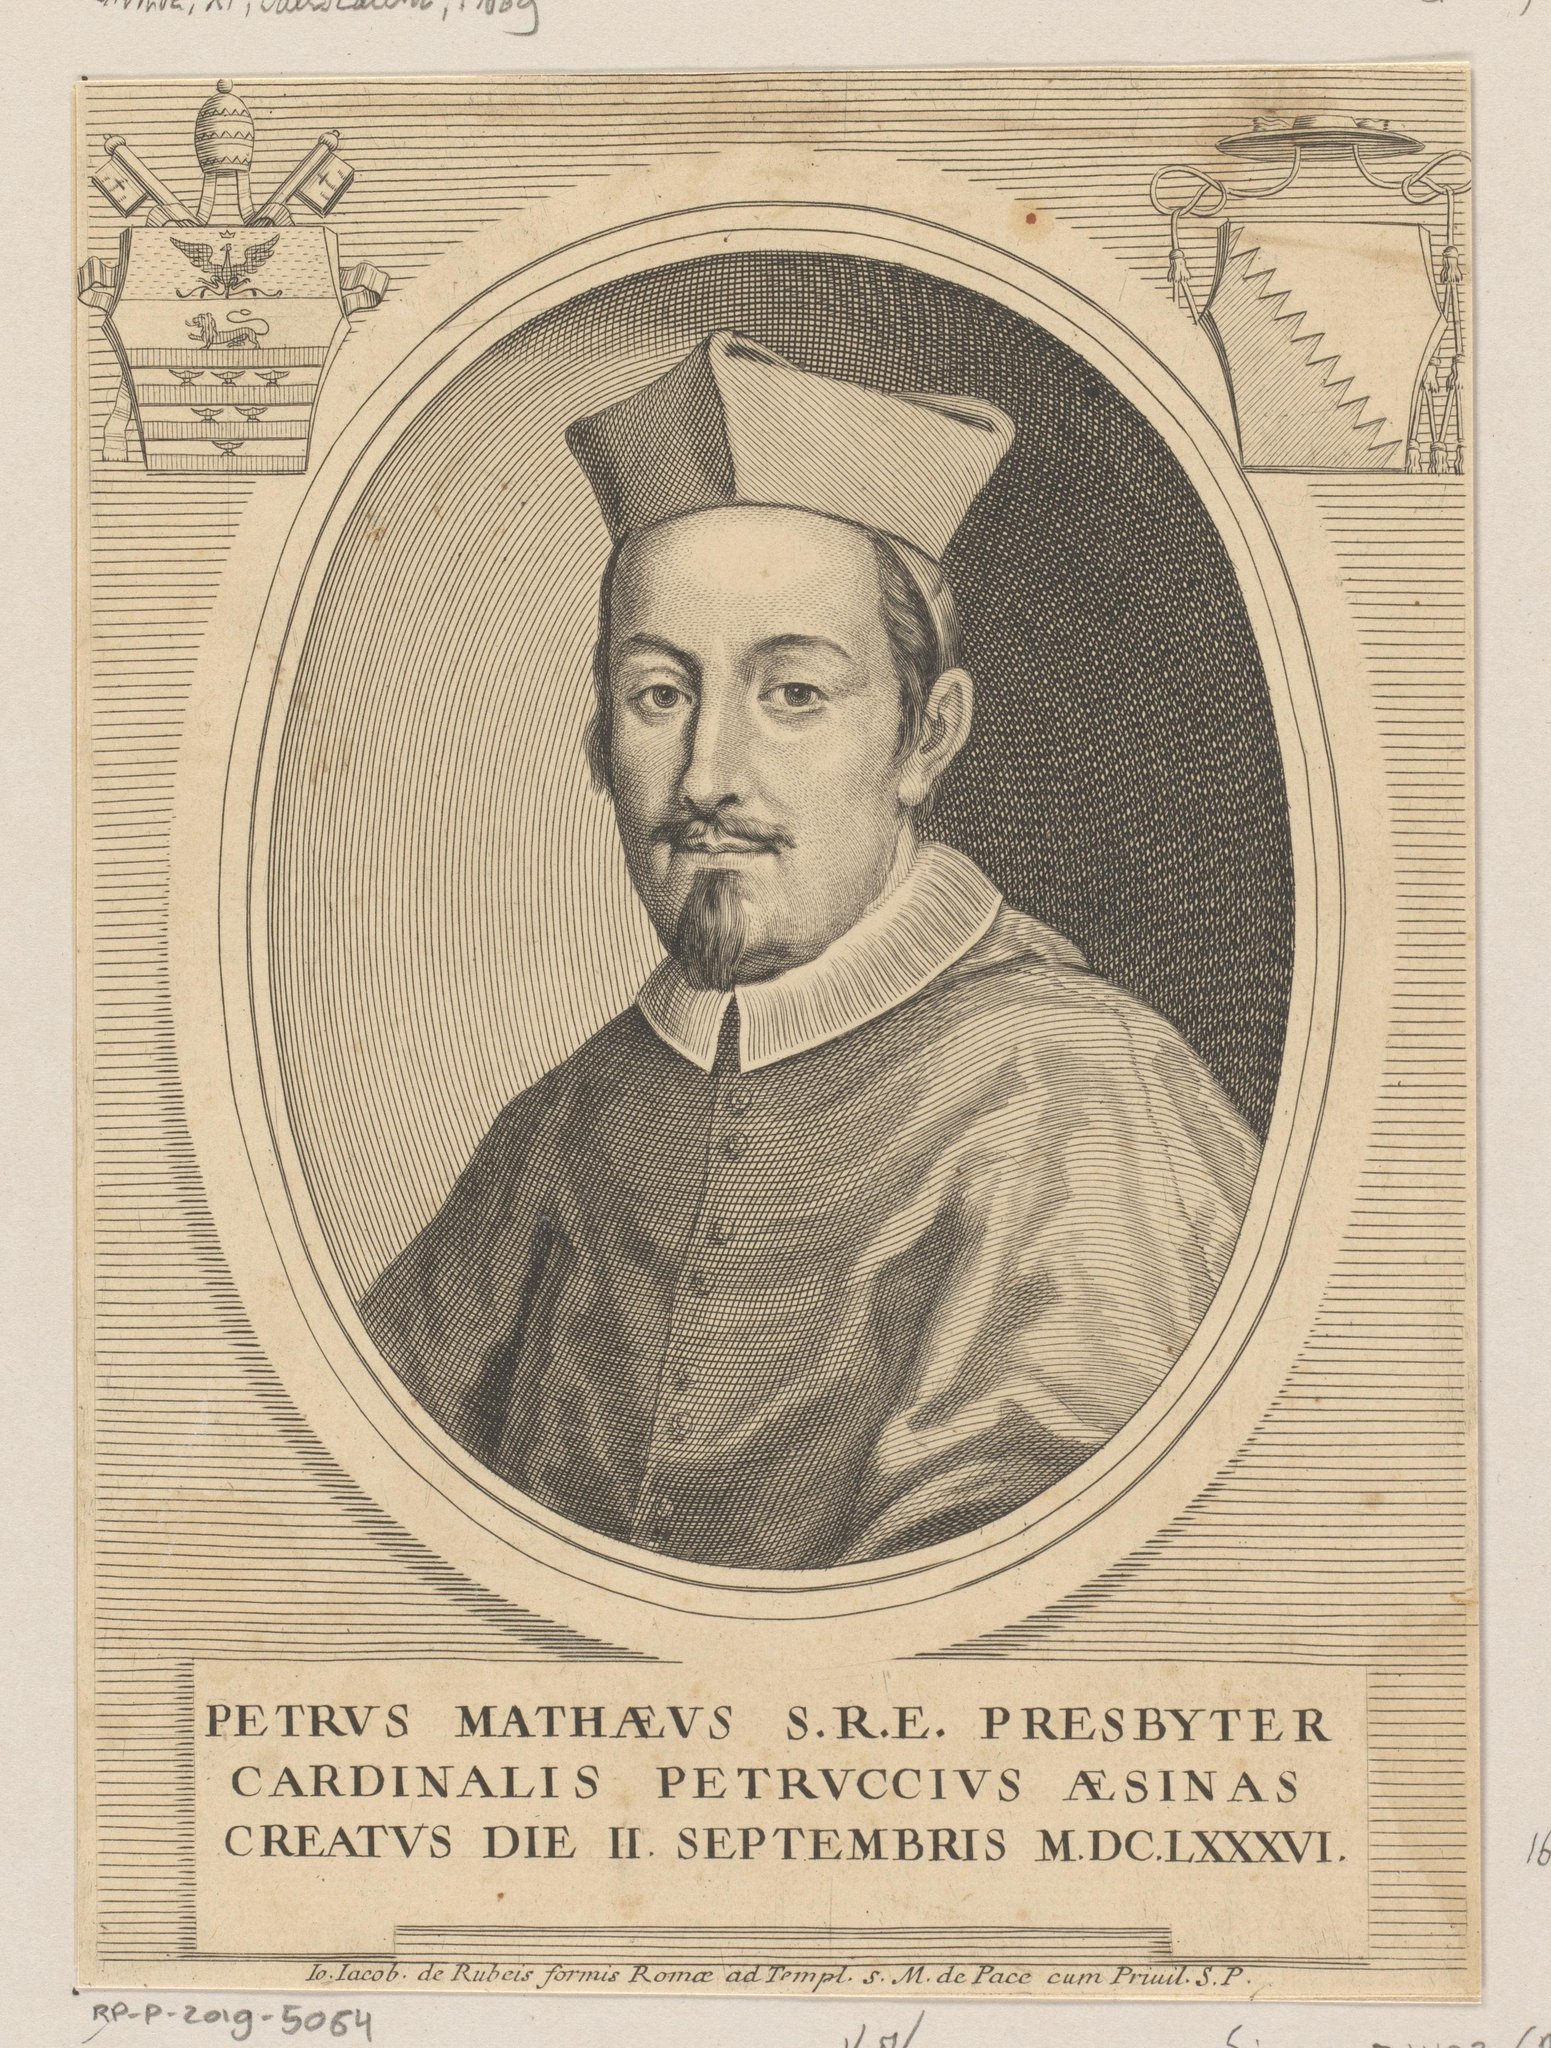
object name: print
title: Effigies cardinalium nunc viventium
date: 1686-1691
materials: paper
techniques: engraving, etching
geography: rome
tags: cardinal, historical persons, armorial bearing, heraldry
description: Met rechtsboven zijn wapenschild en linksboven het wapen van paus Innocentius XI.